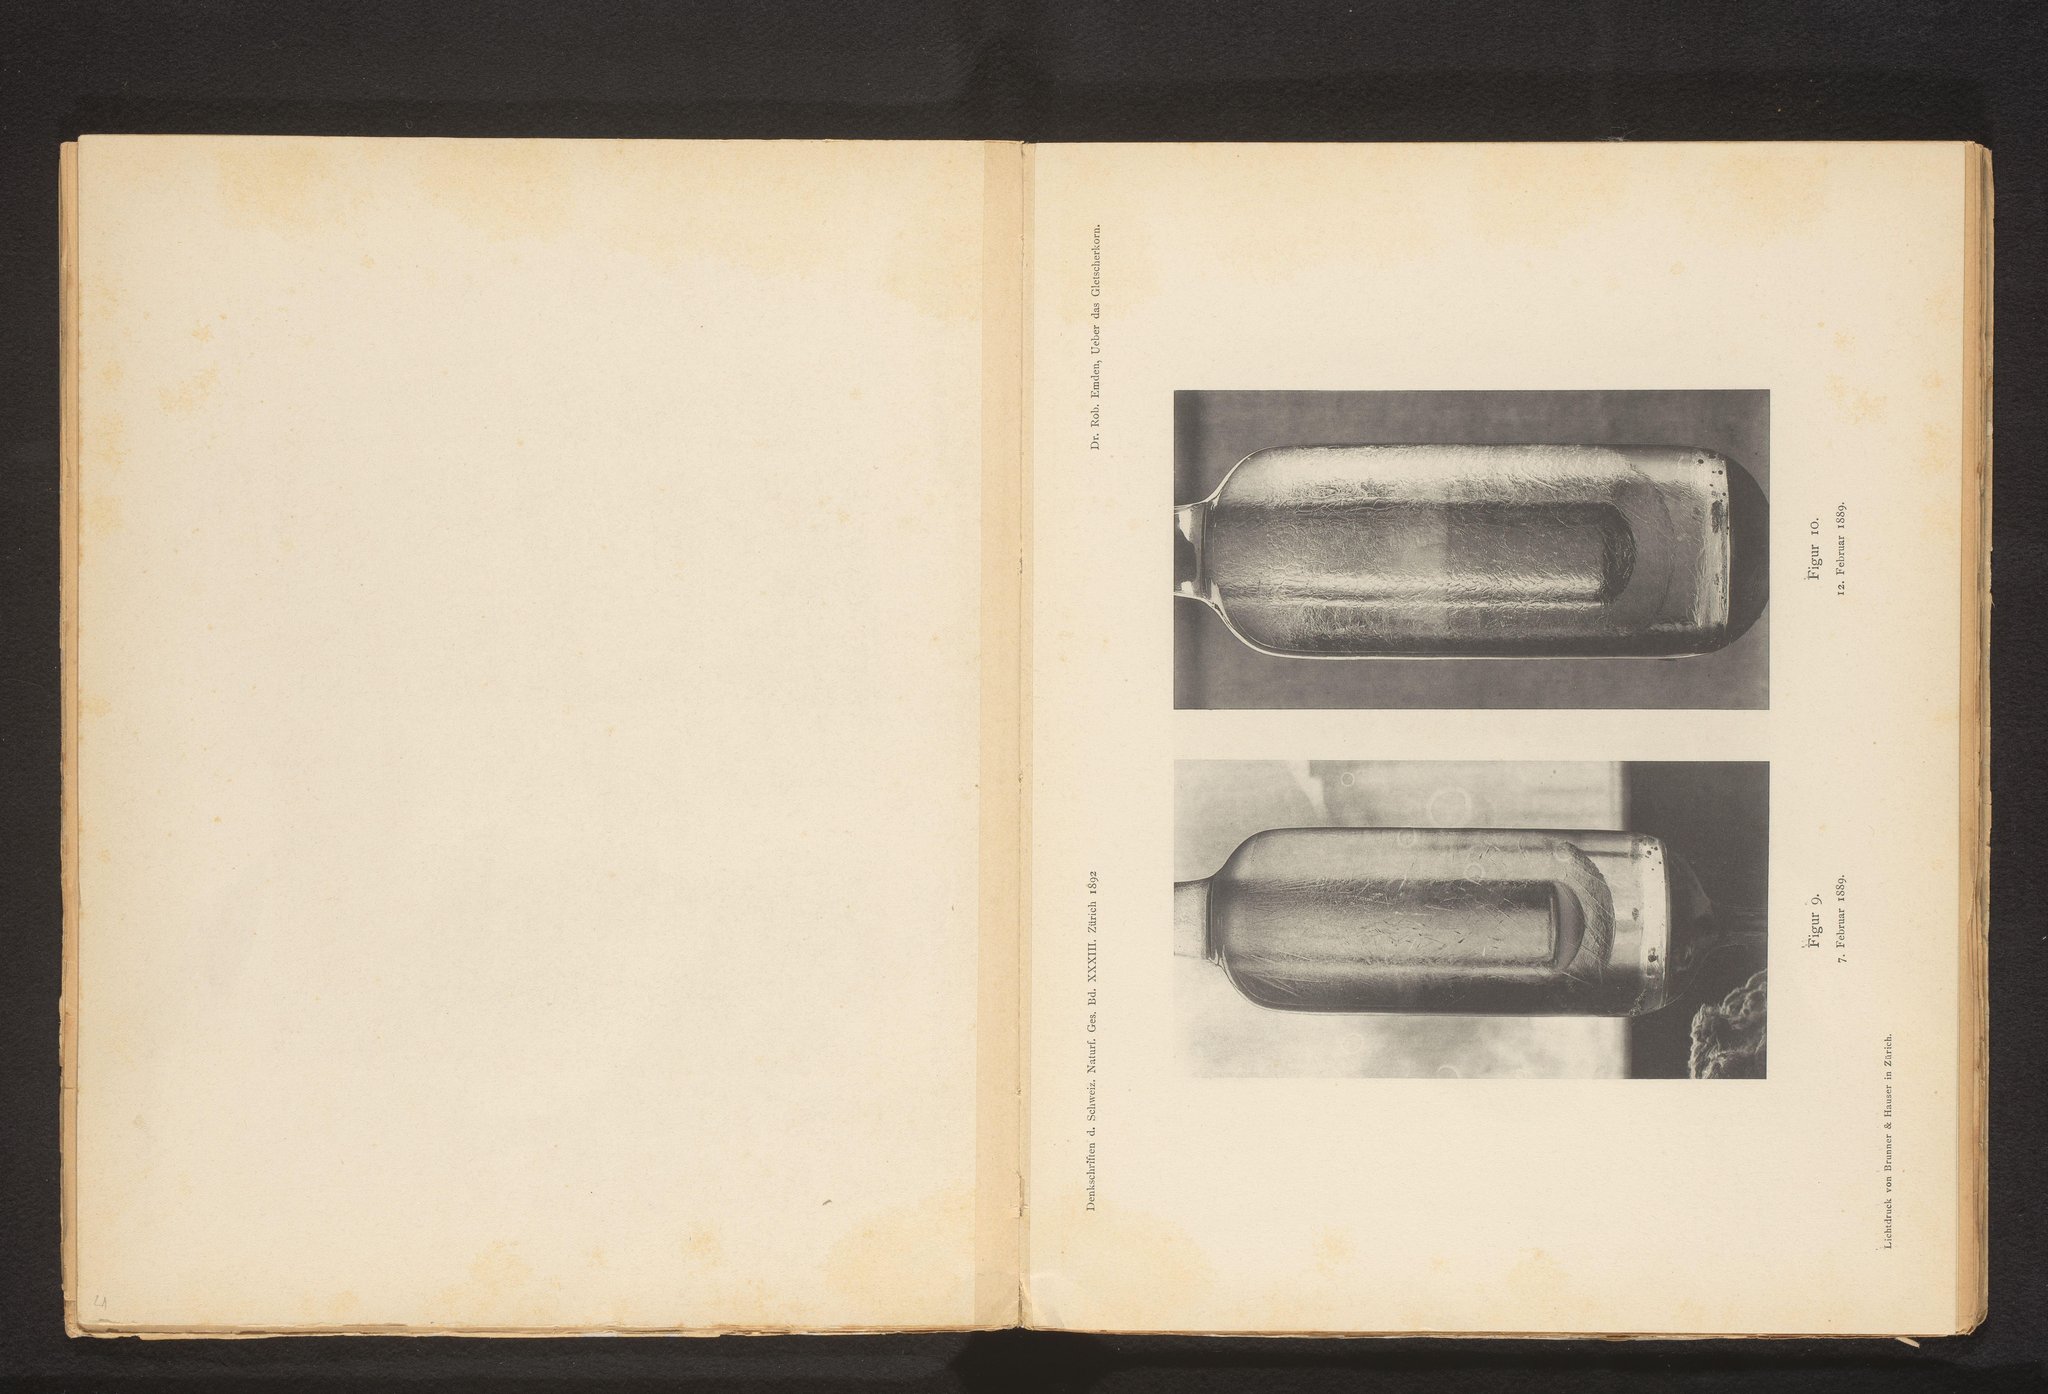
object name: page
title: Flessen met ijs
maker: Anonymous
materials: paper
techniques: photograph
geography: zurich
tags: container of glass: bottle, jar, vase, ice ~ state of water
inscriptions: number: ‘Figur 9. Figur 10.’